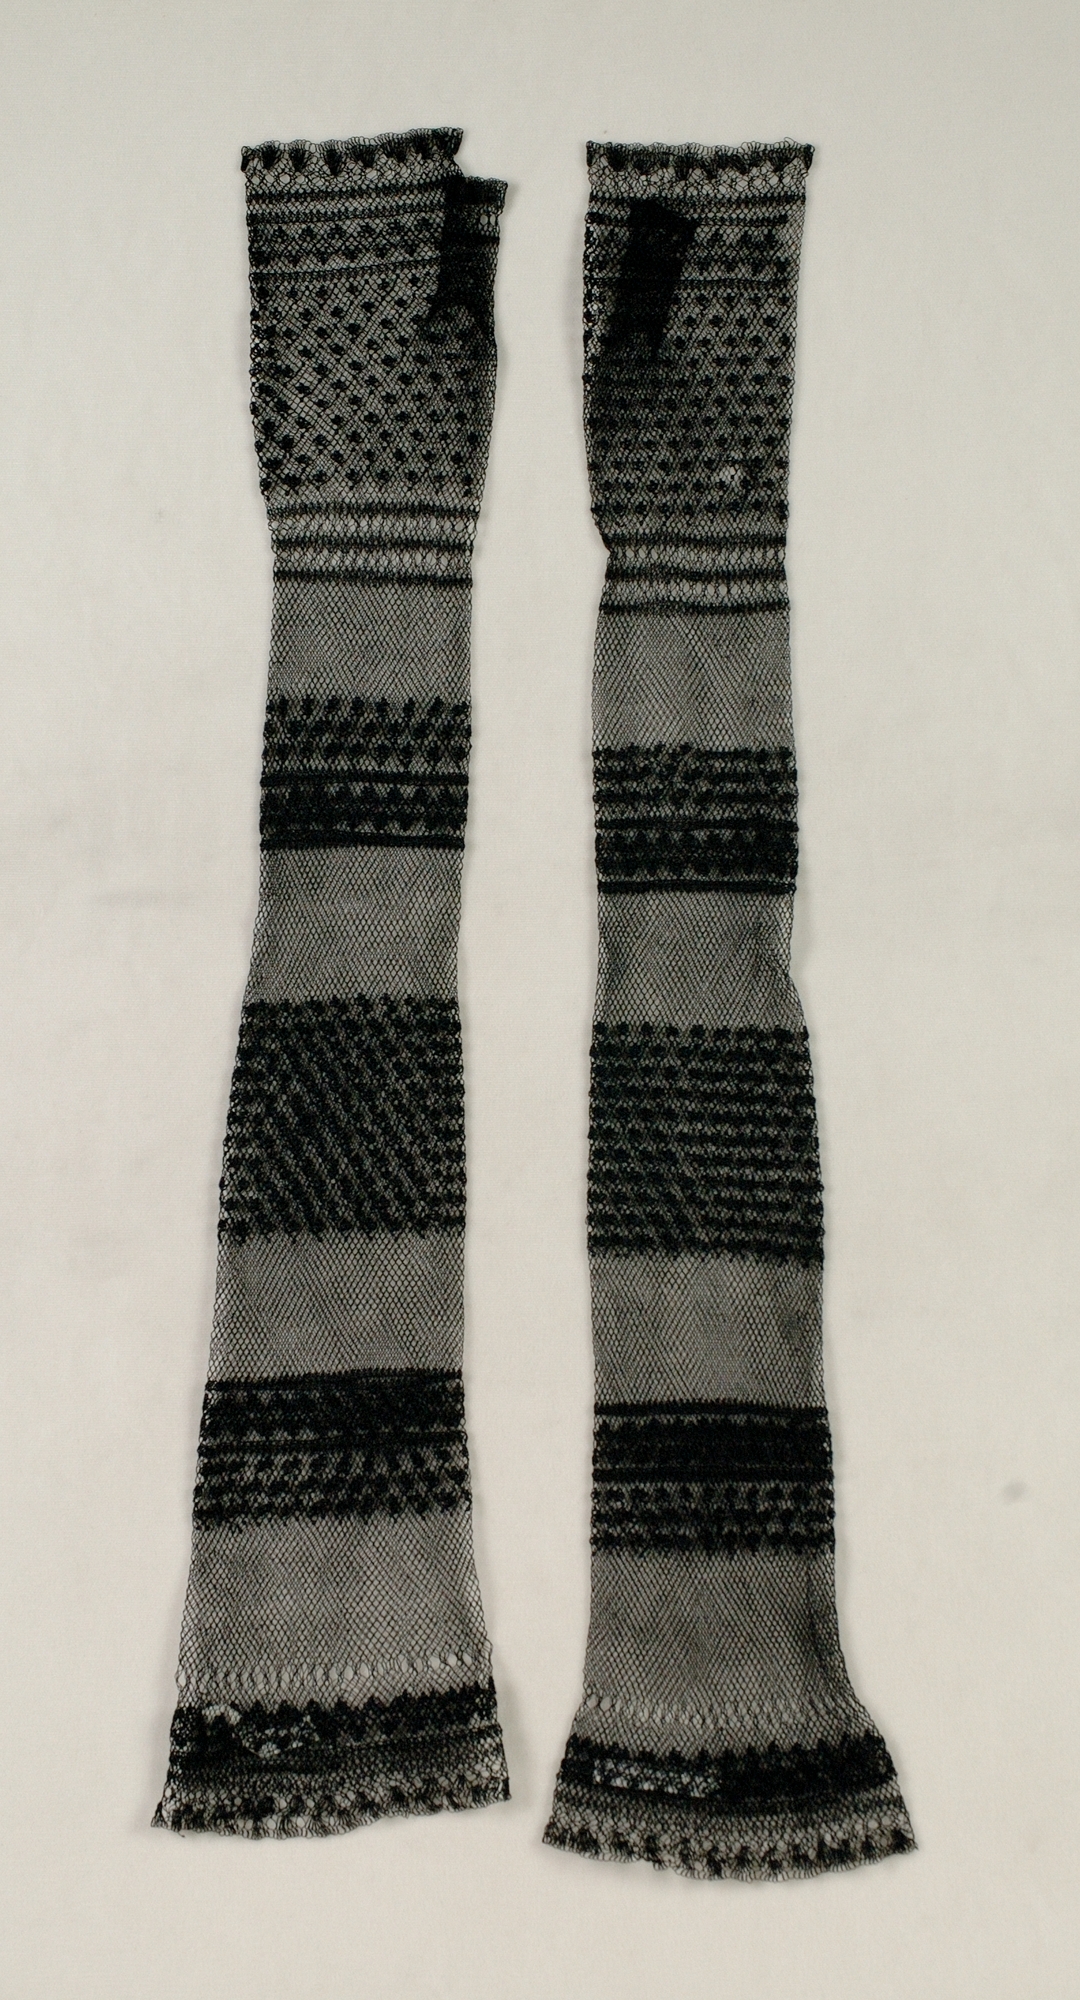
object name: evening mitt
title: Evening mitts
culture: american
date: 1876-1900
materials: silk